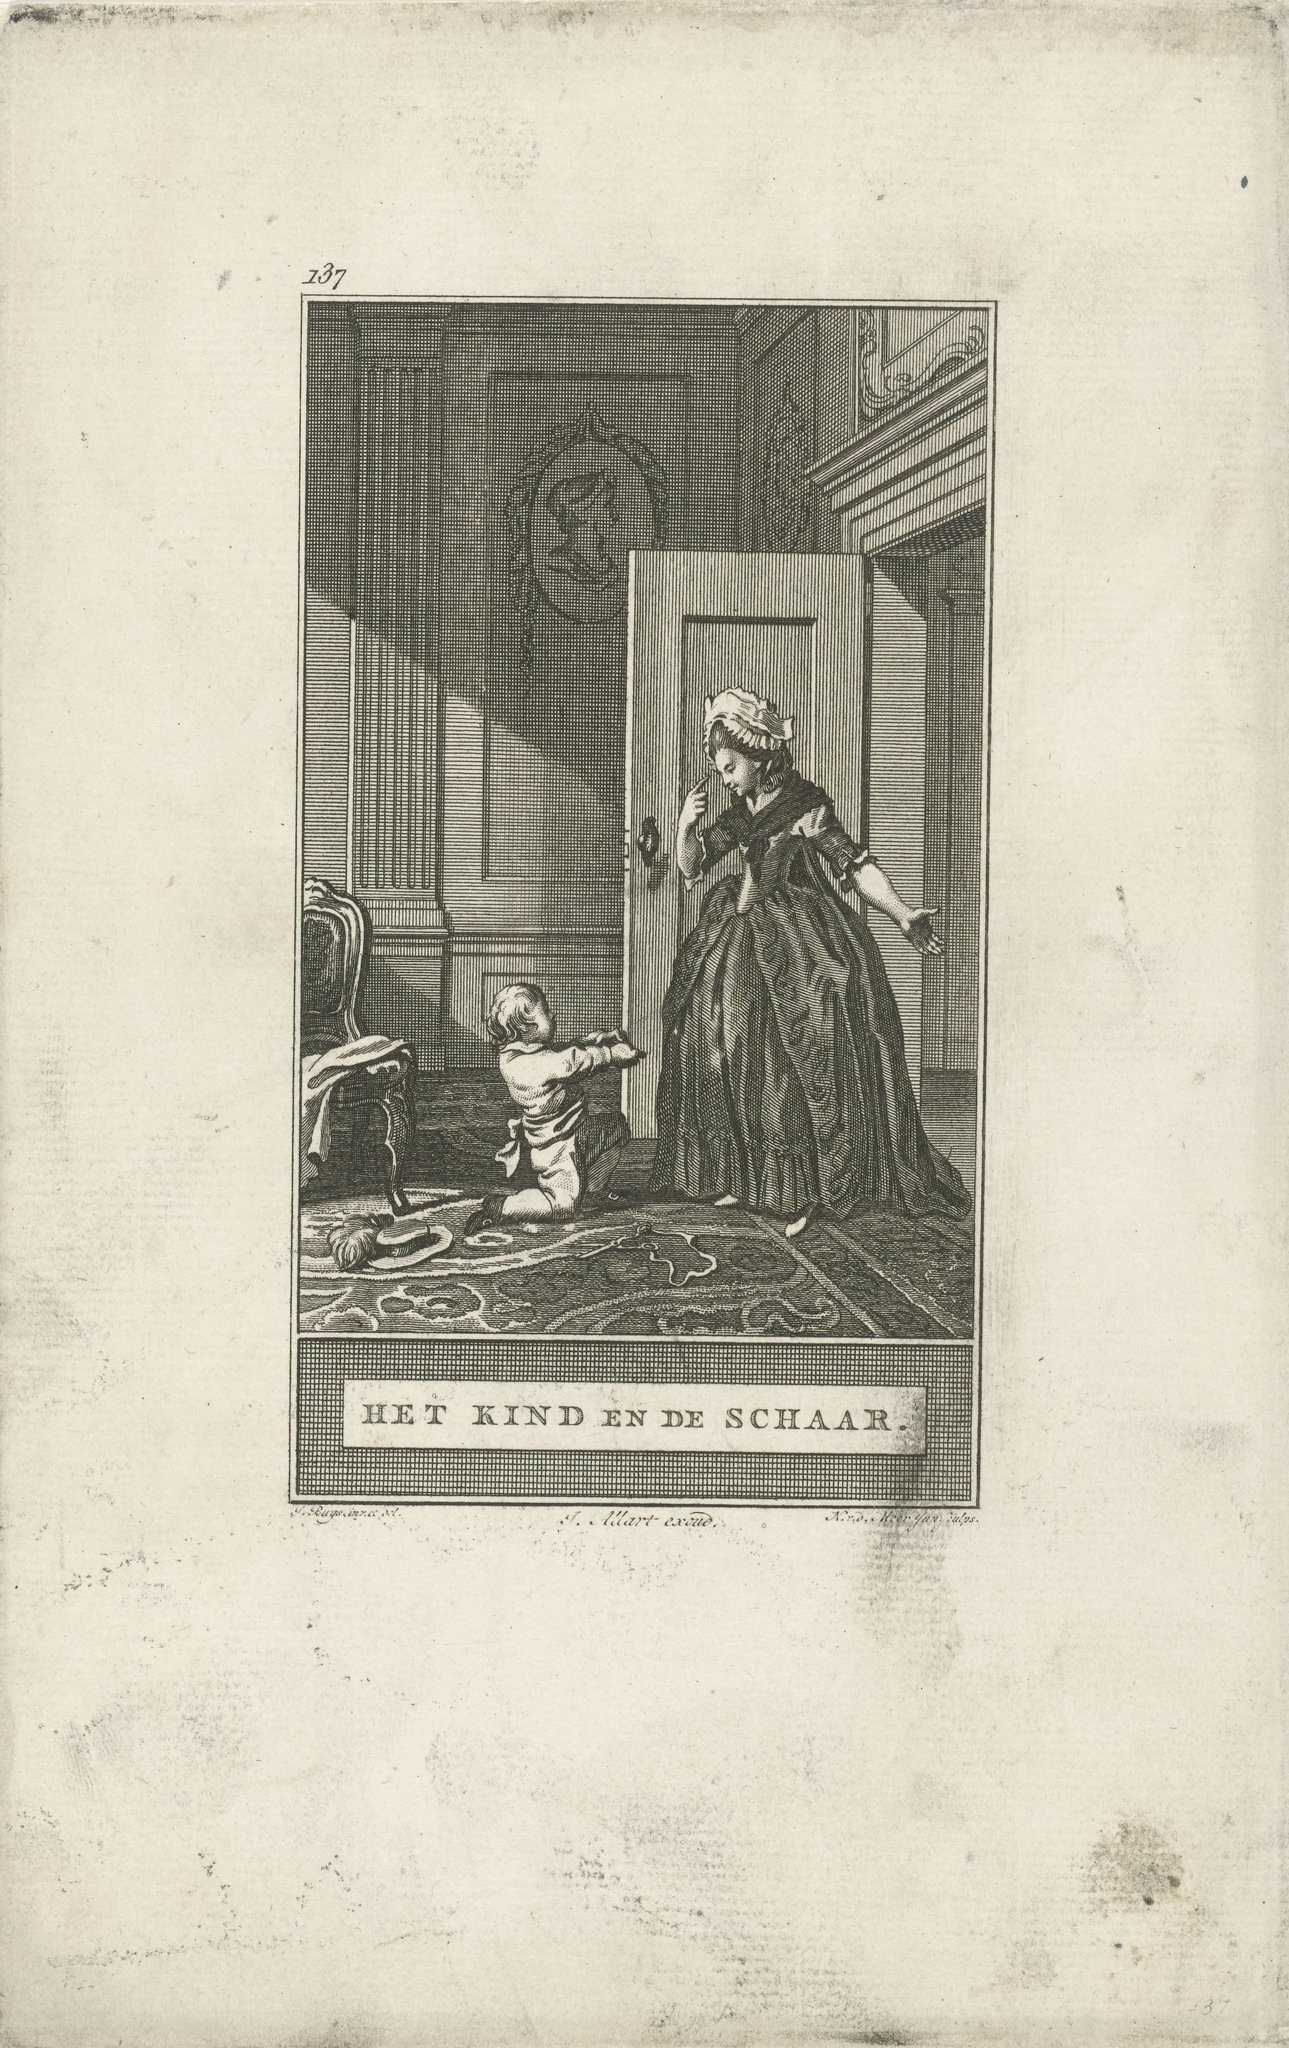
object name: print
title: Het kind en de schaar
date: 1778-1785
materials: paper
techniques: etching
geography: amsterdam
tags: mother and baby or young child, tools, aids, implements ~ crafts and industries: scissors, living-room, parlour, sitting-room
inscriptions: collector's mark: Lugt 2228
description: Prent bij: Gellert, Christian Fürchtegott. Fabelen en vertelsels. 3 dln. Amsterdam: Pieter Meyer, 1772-1774. De prenten bij deze publicatie werden later uitgegeven. De exemplaren uitgegeven door de weduwe Jacobus Loveringh & Johannes Allart tussen 1777 en 1778, de exemplaren uitgegeven door alleen Johannes Allart tussen 1778 en 1785.